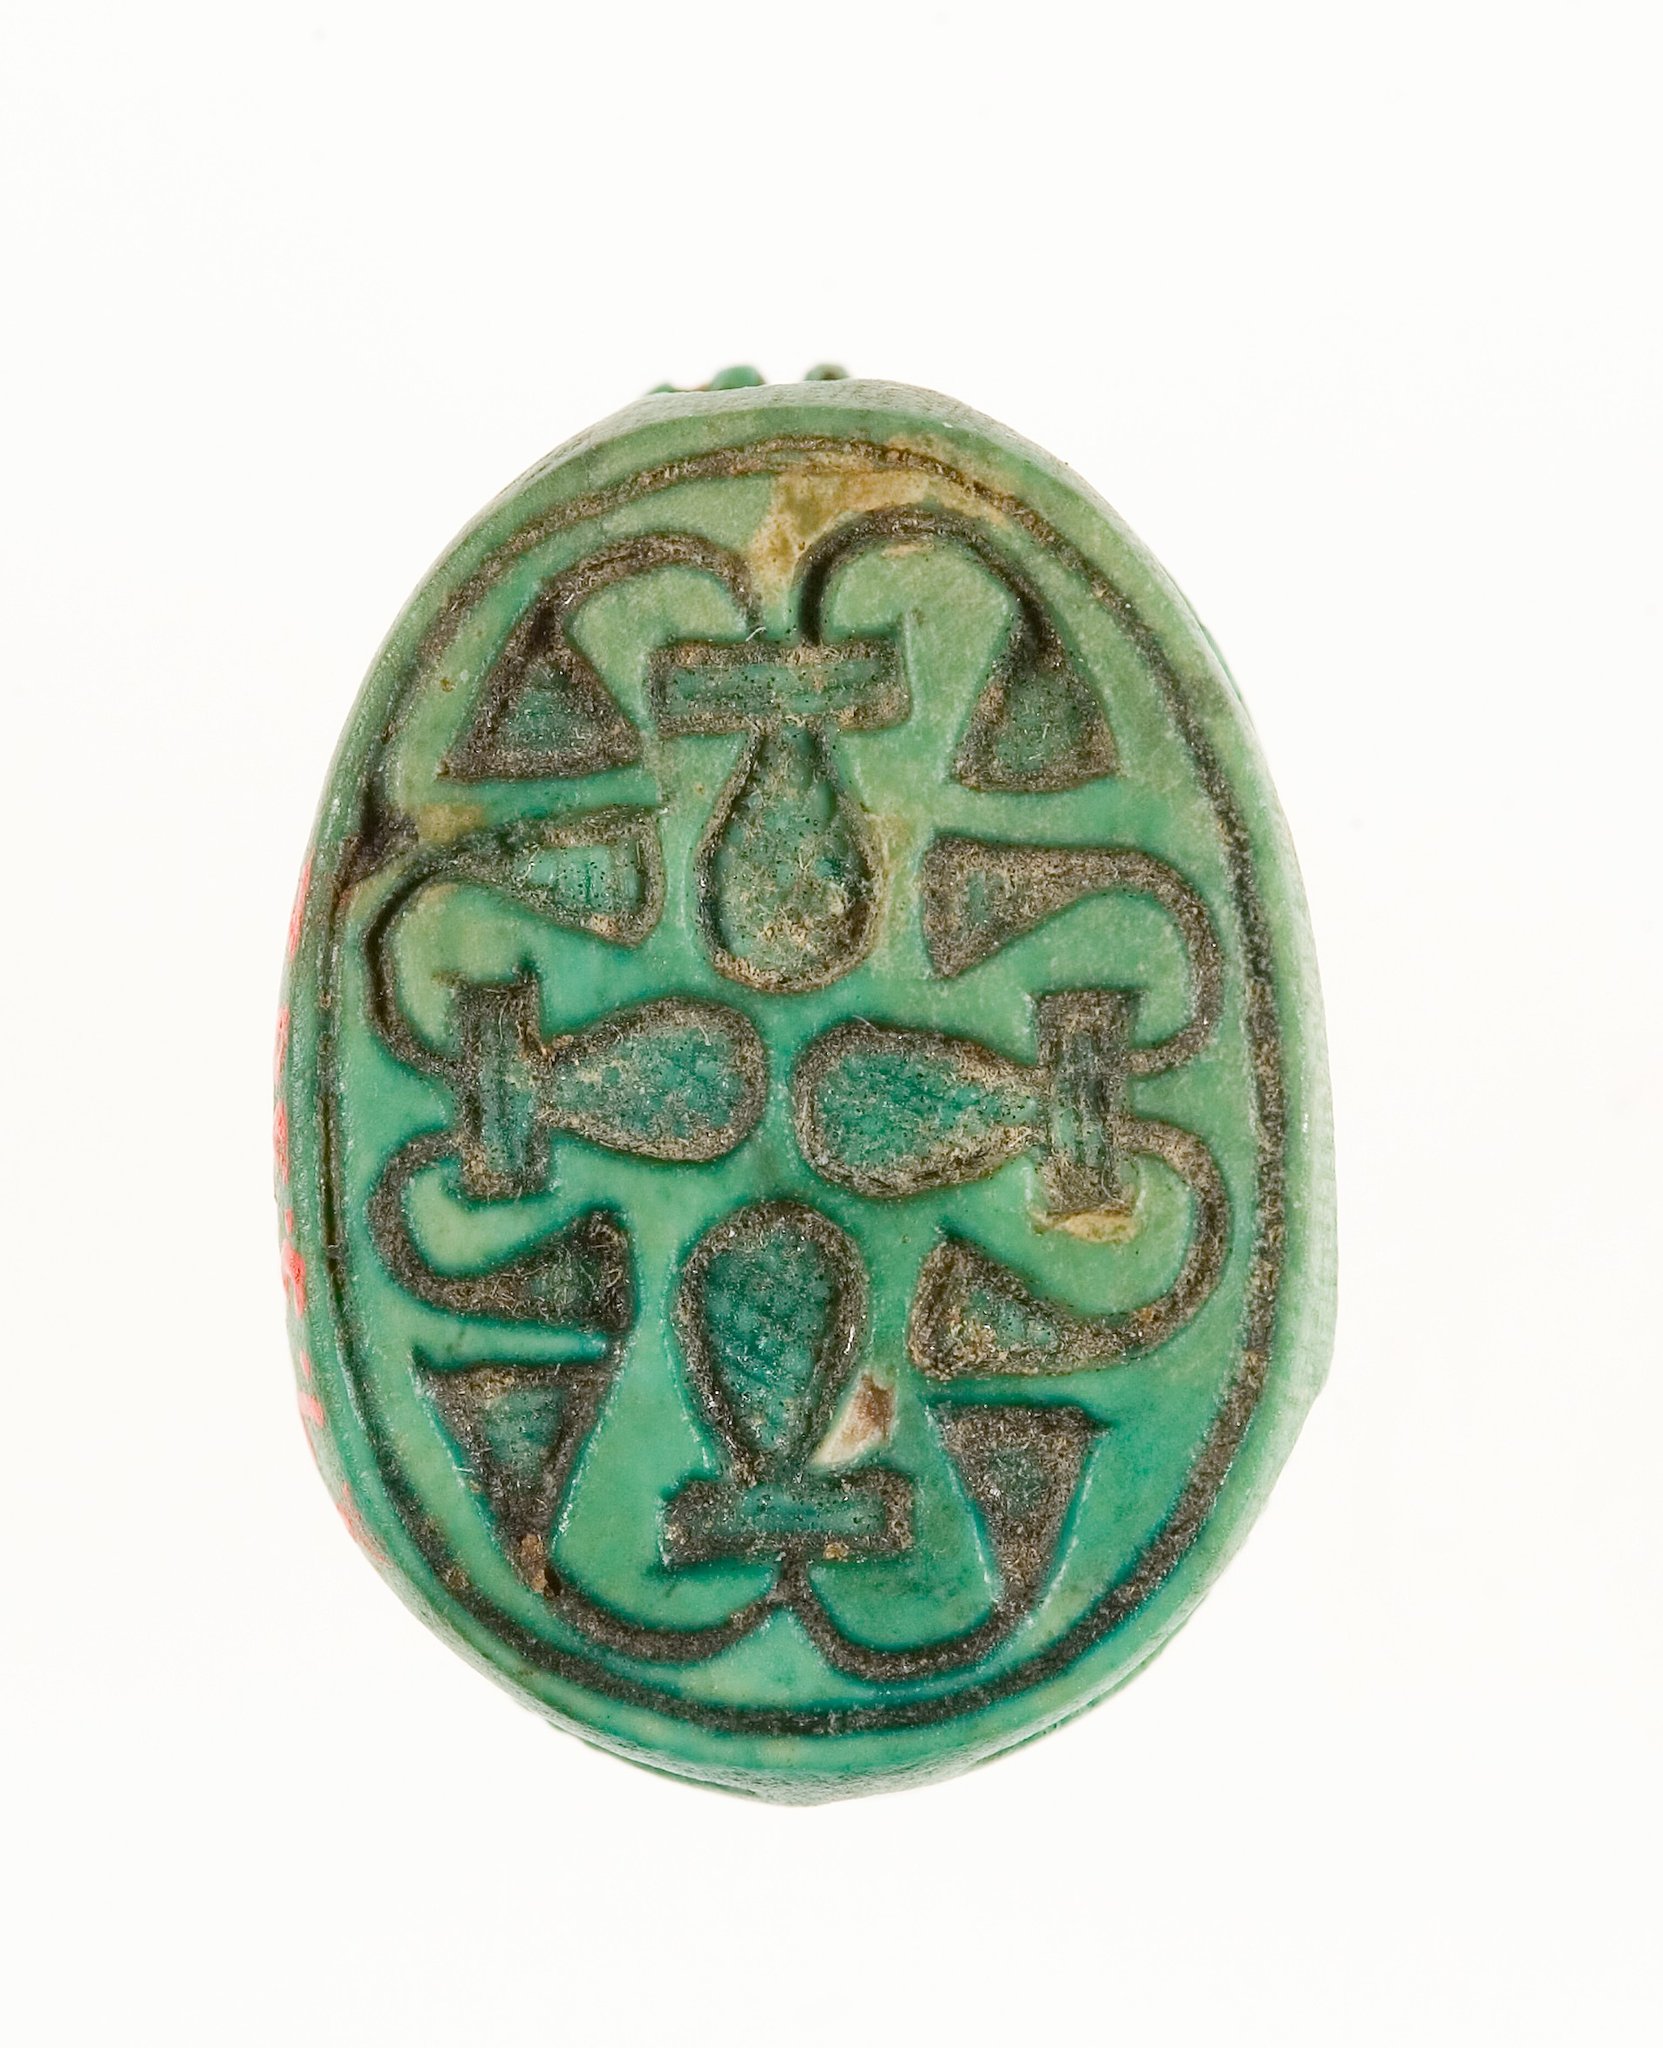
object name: scarab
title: Scarab Inscribed with a Geometric Pattern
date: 1479-1458 BCE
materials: stone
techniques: glazing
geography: egypt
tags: scarabs